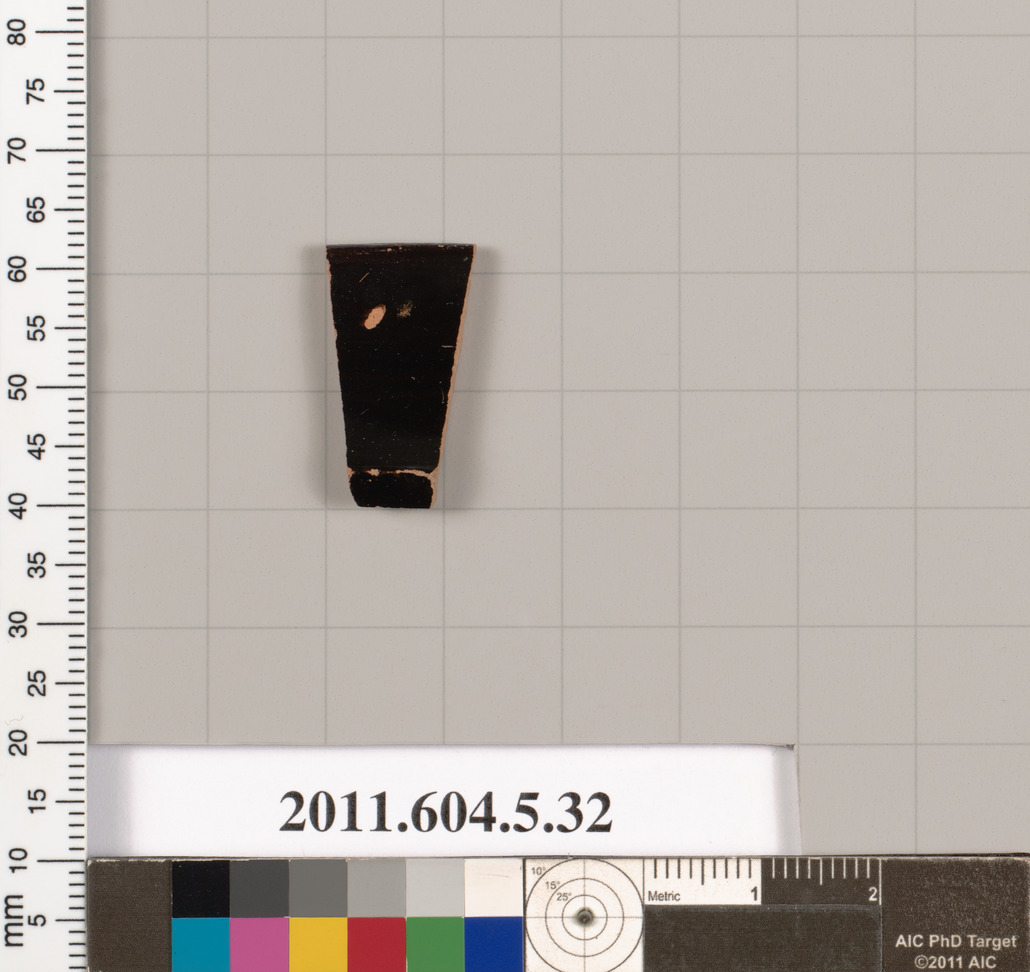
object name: kylix fragment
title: Terracotta rim fragment of a kylix (drinking cup)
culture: greek, attic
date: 500-401 BCE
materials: terracotta